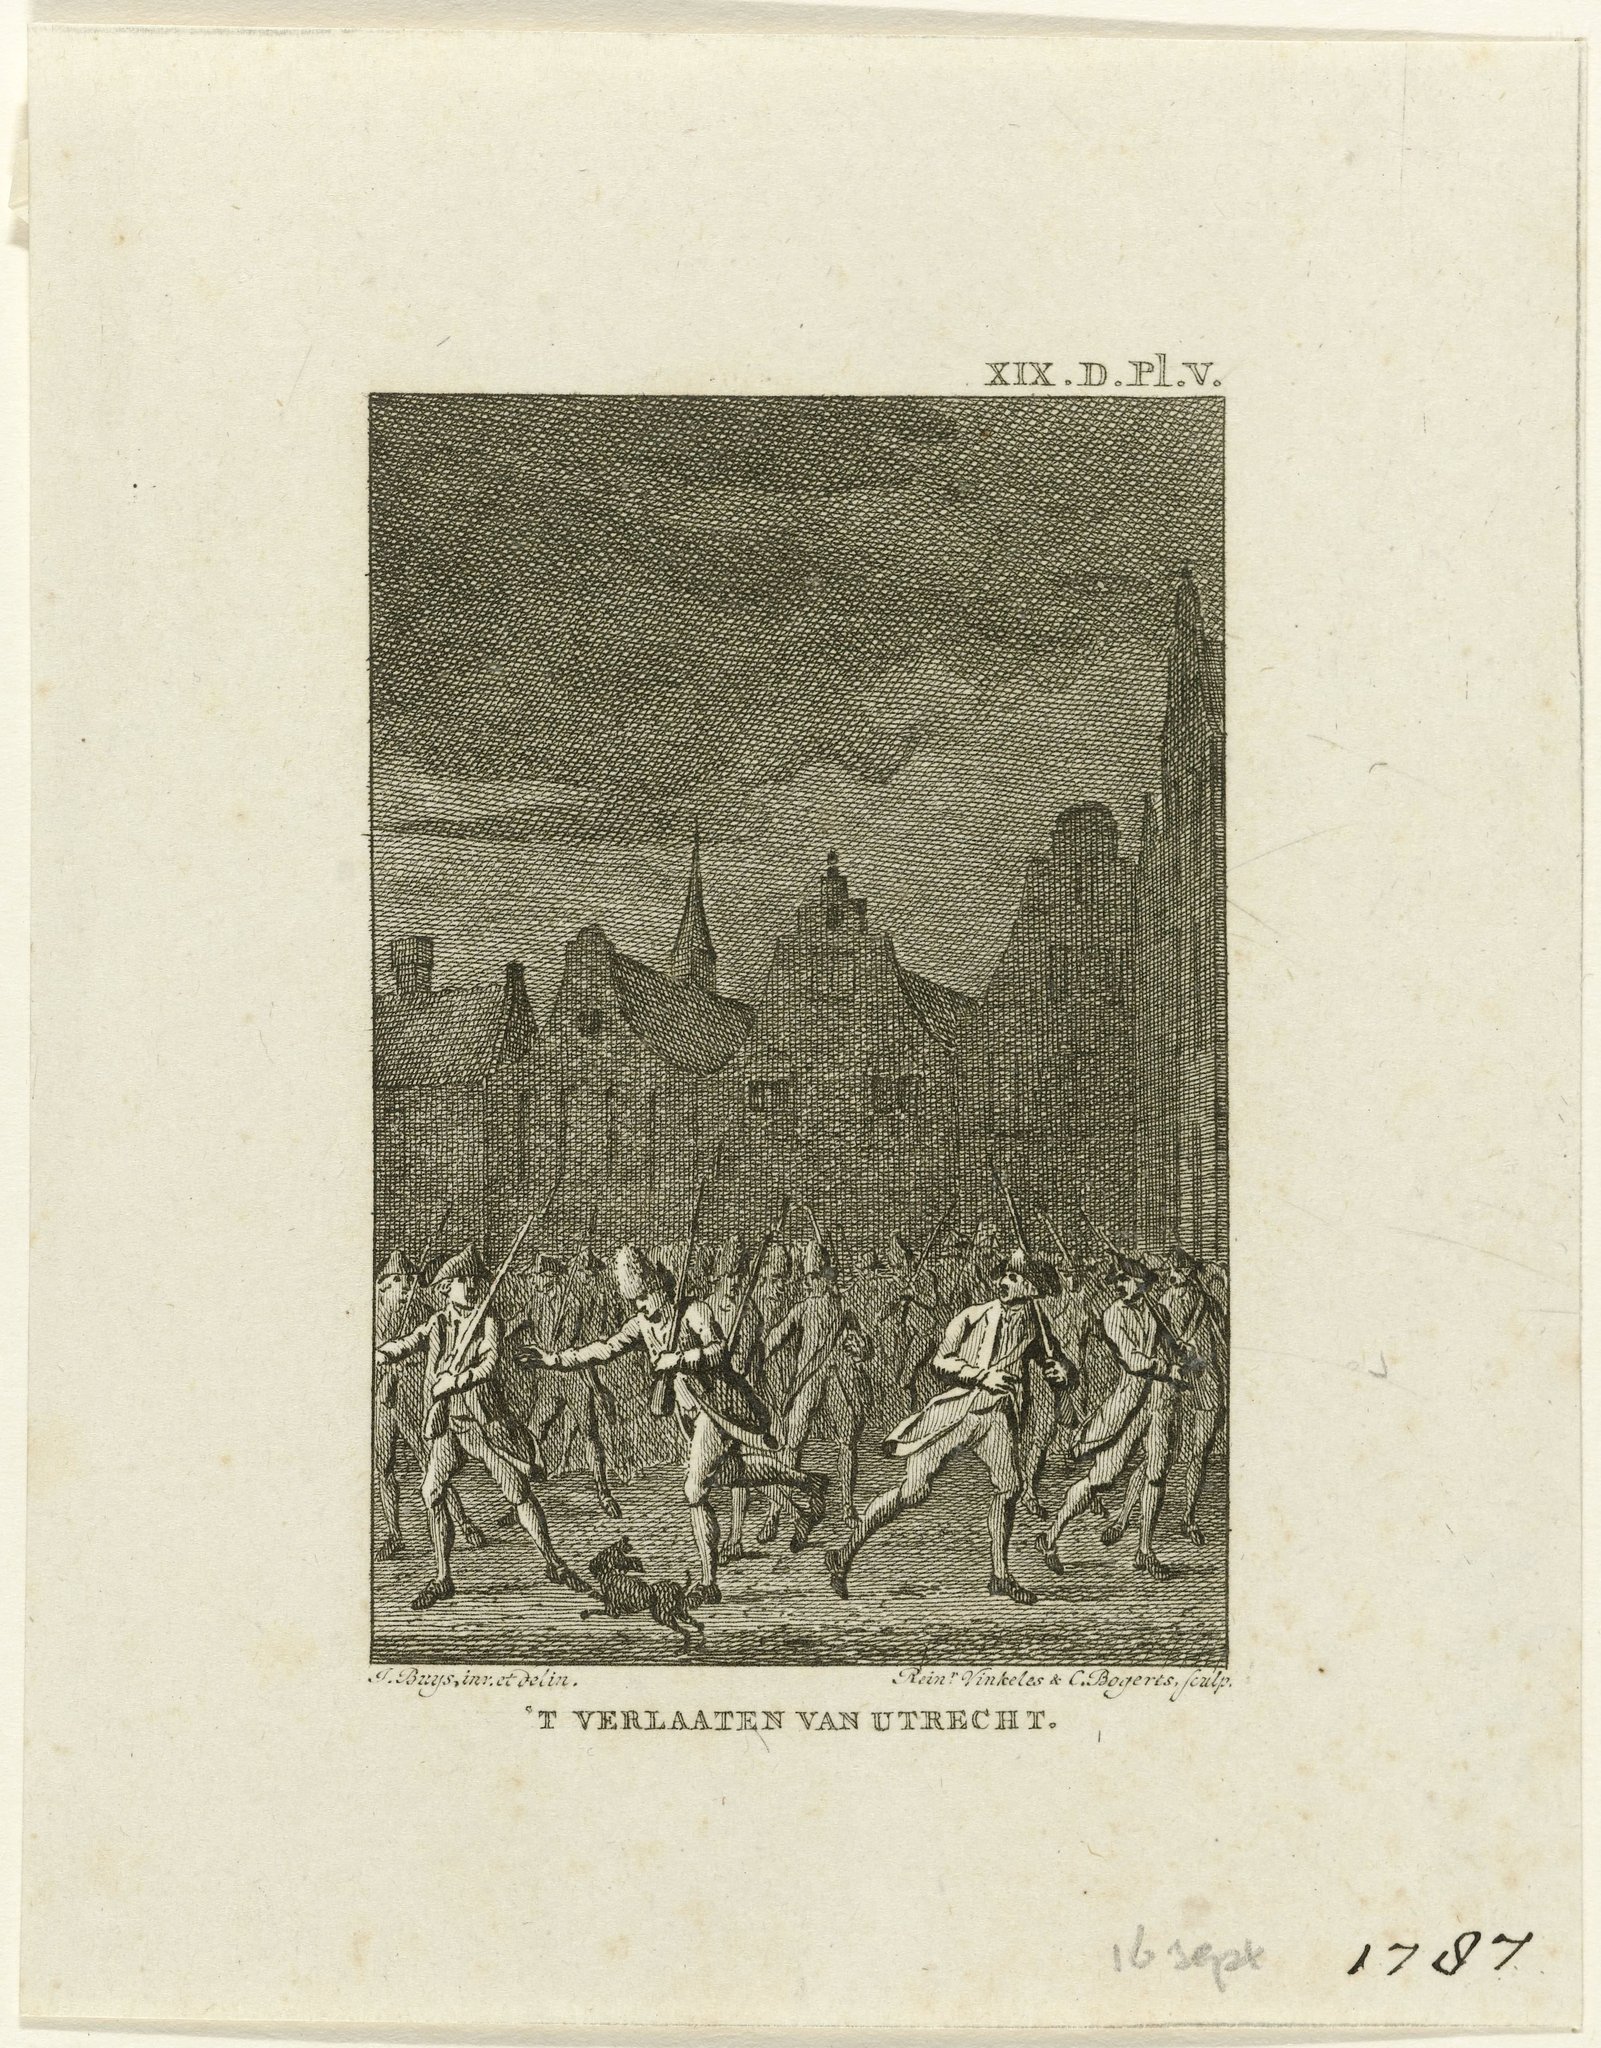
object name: history print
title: 't Verlaaten van Utrecht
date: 1787-1795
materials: paper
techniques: engraving, etching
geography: northern netherlands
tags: putting the enemy to flight - hh - being put to flight, fleeing (+ citizen soldiery, civil guard, citizen militia), utrecht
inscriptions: collector's mark: Lugt 2228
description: Gebruikt als illustratie in: J. Fokke, Geschiedenissen der Vereenigde Nederlanden voor de vaderlandsche jeugd, Johannes Allart, Amsterdam 1783-1795, 25 delen, dl. 19, pl. 5.